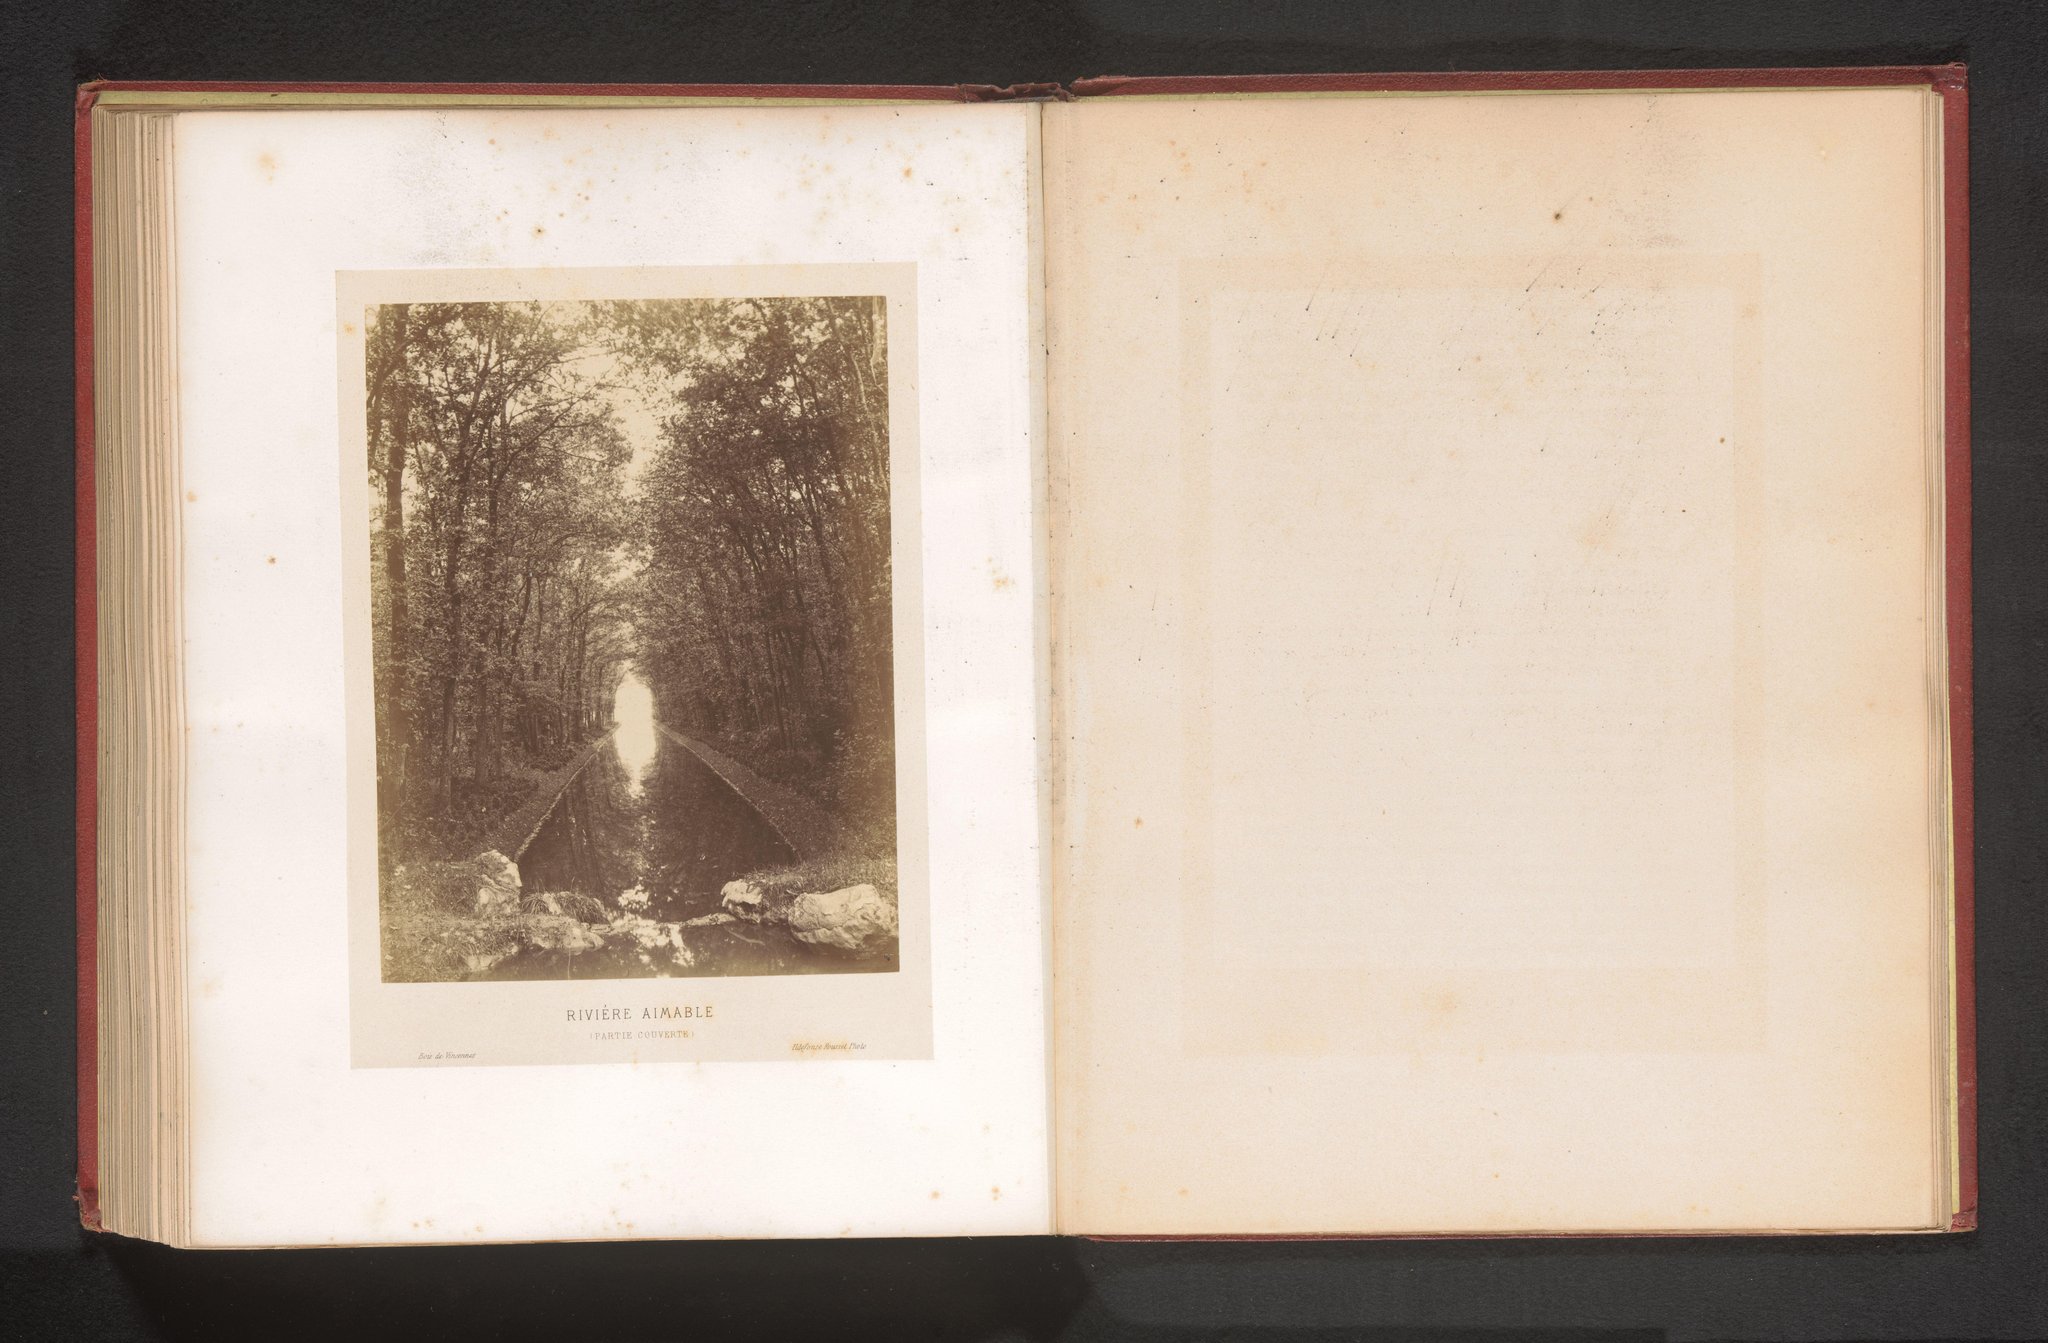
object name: page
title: Rivier in het Bois de Vincennes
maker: ildefonse rousset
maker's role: fotograaf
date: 1861-1866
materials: photographic support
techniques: albumen print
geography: bois de vincennes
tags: river, public gardens, park